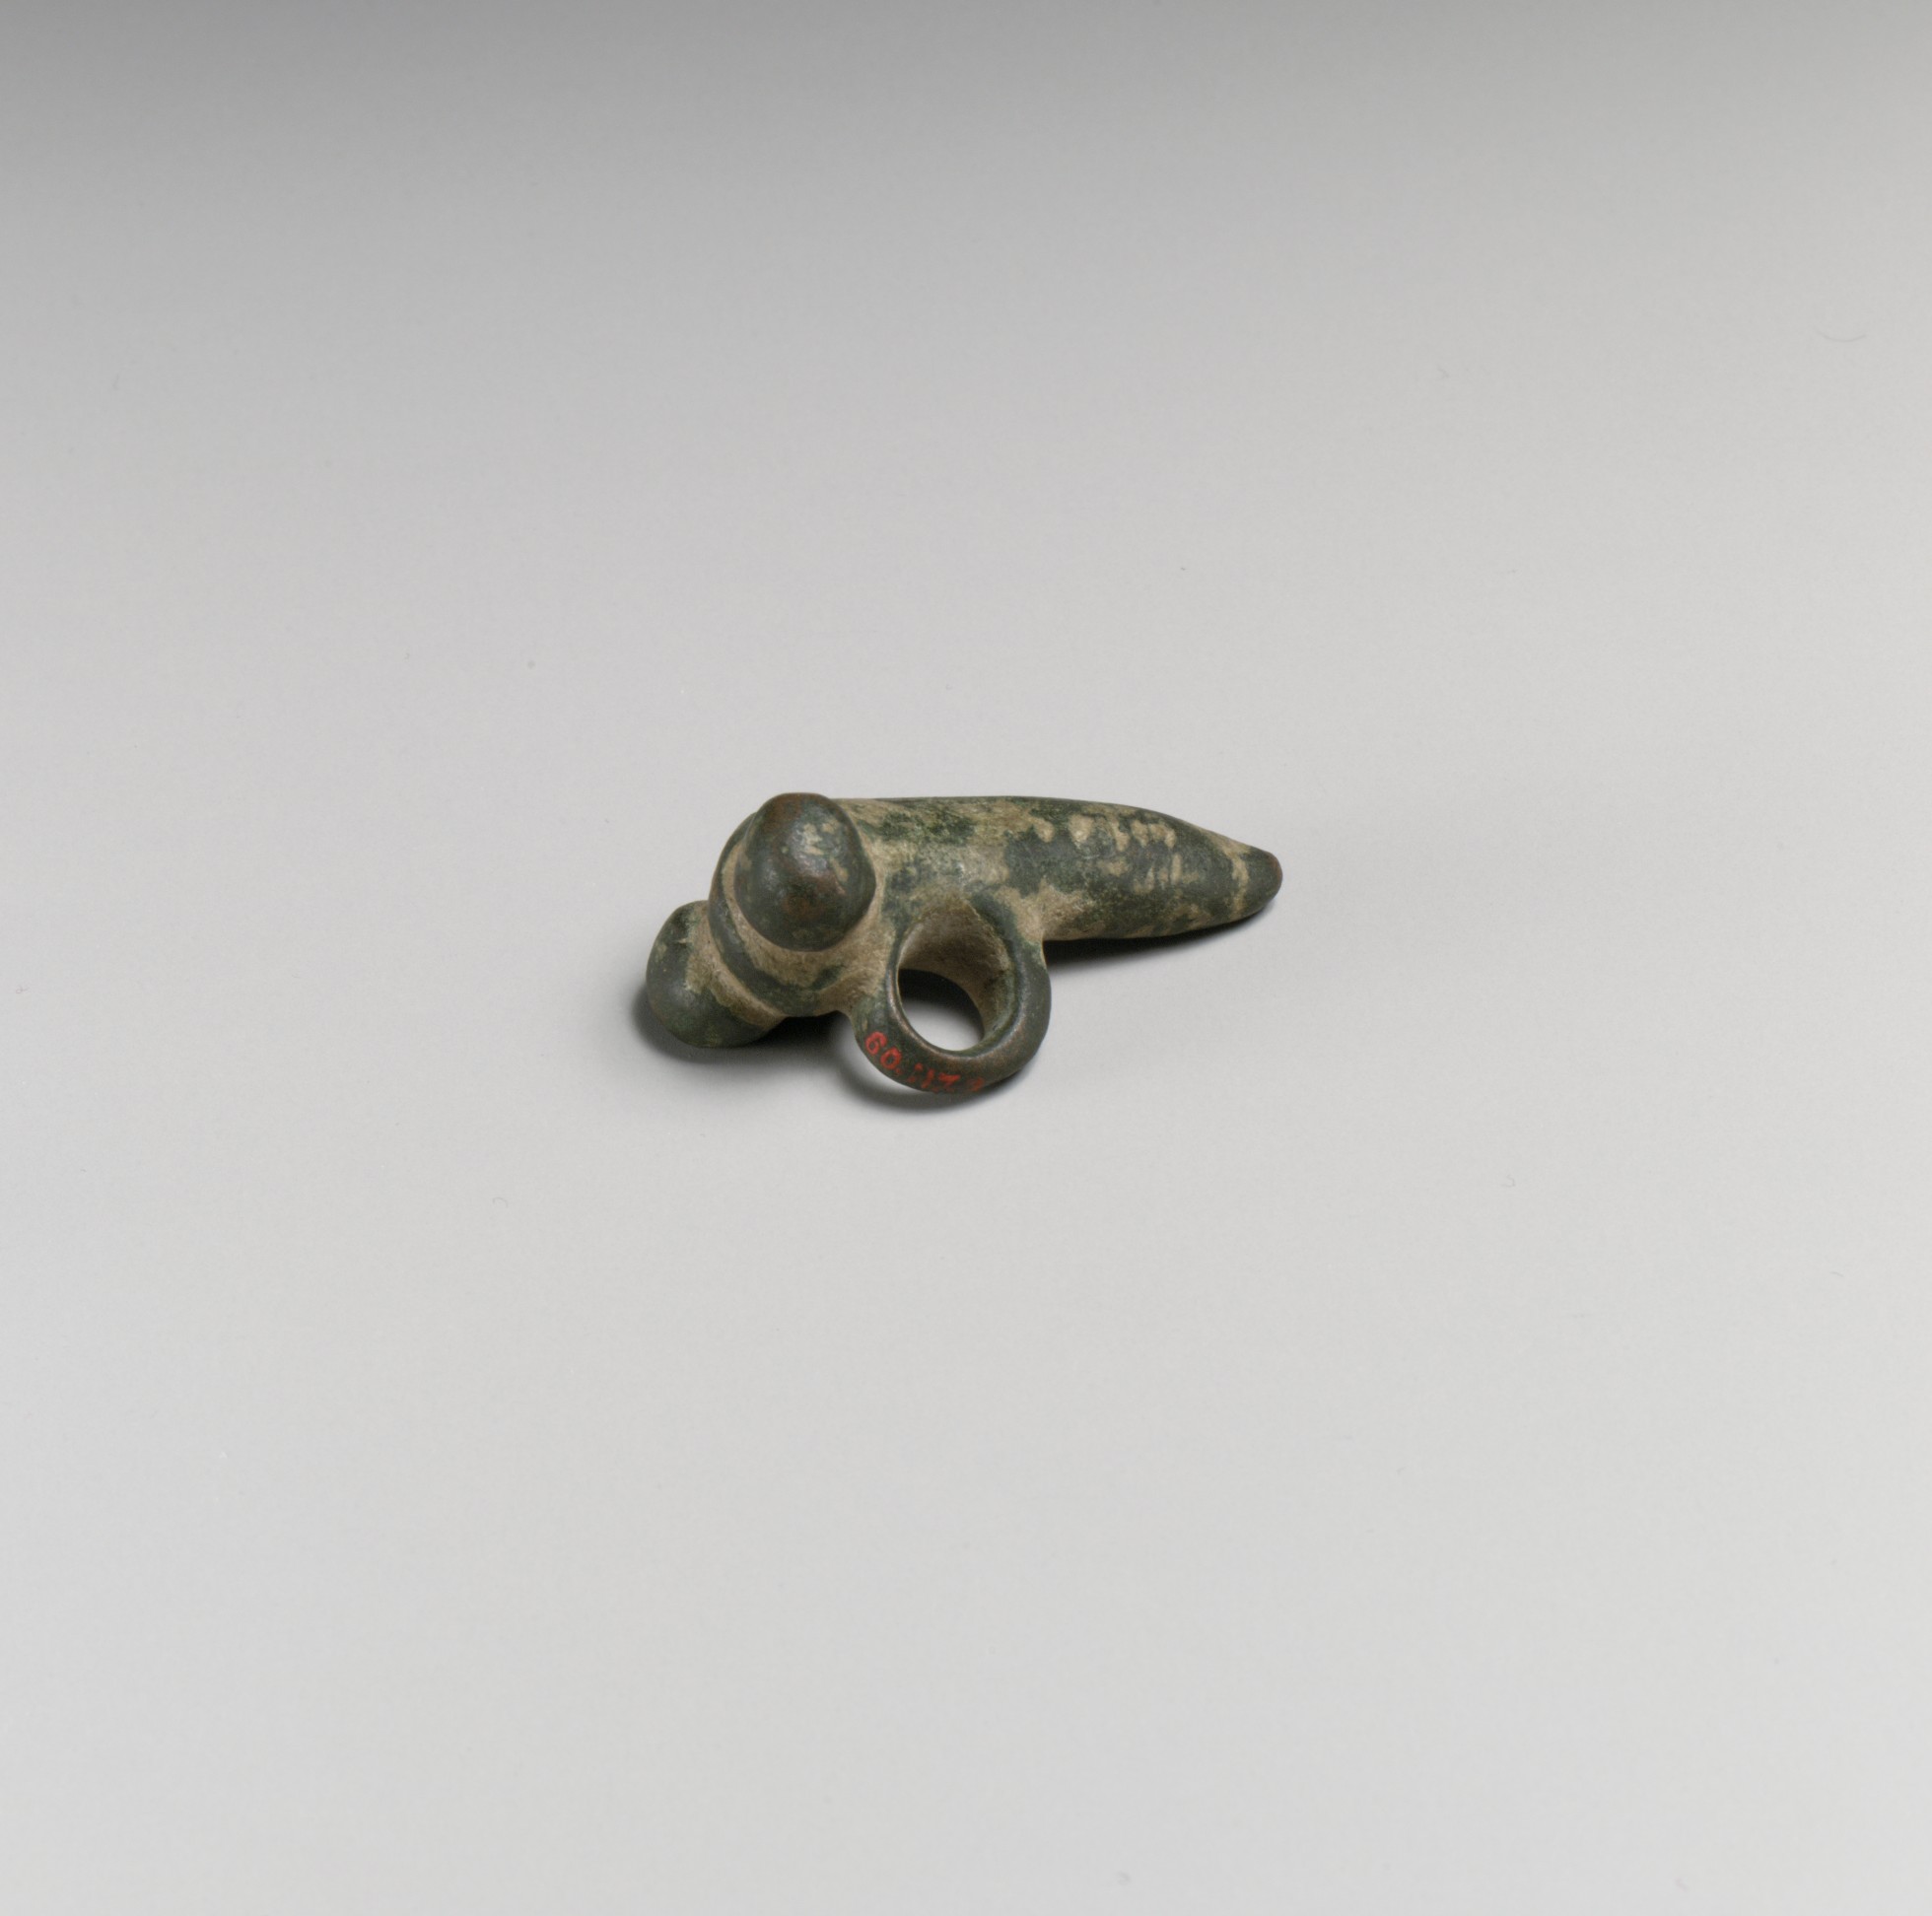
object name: amulet, grotesque ornament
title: Bronze phallic amulet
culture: roman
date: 1-100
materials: bronze